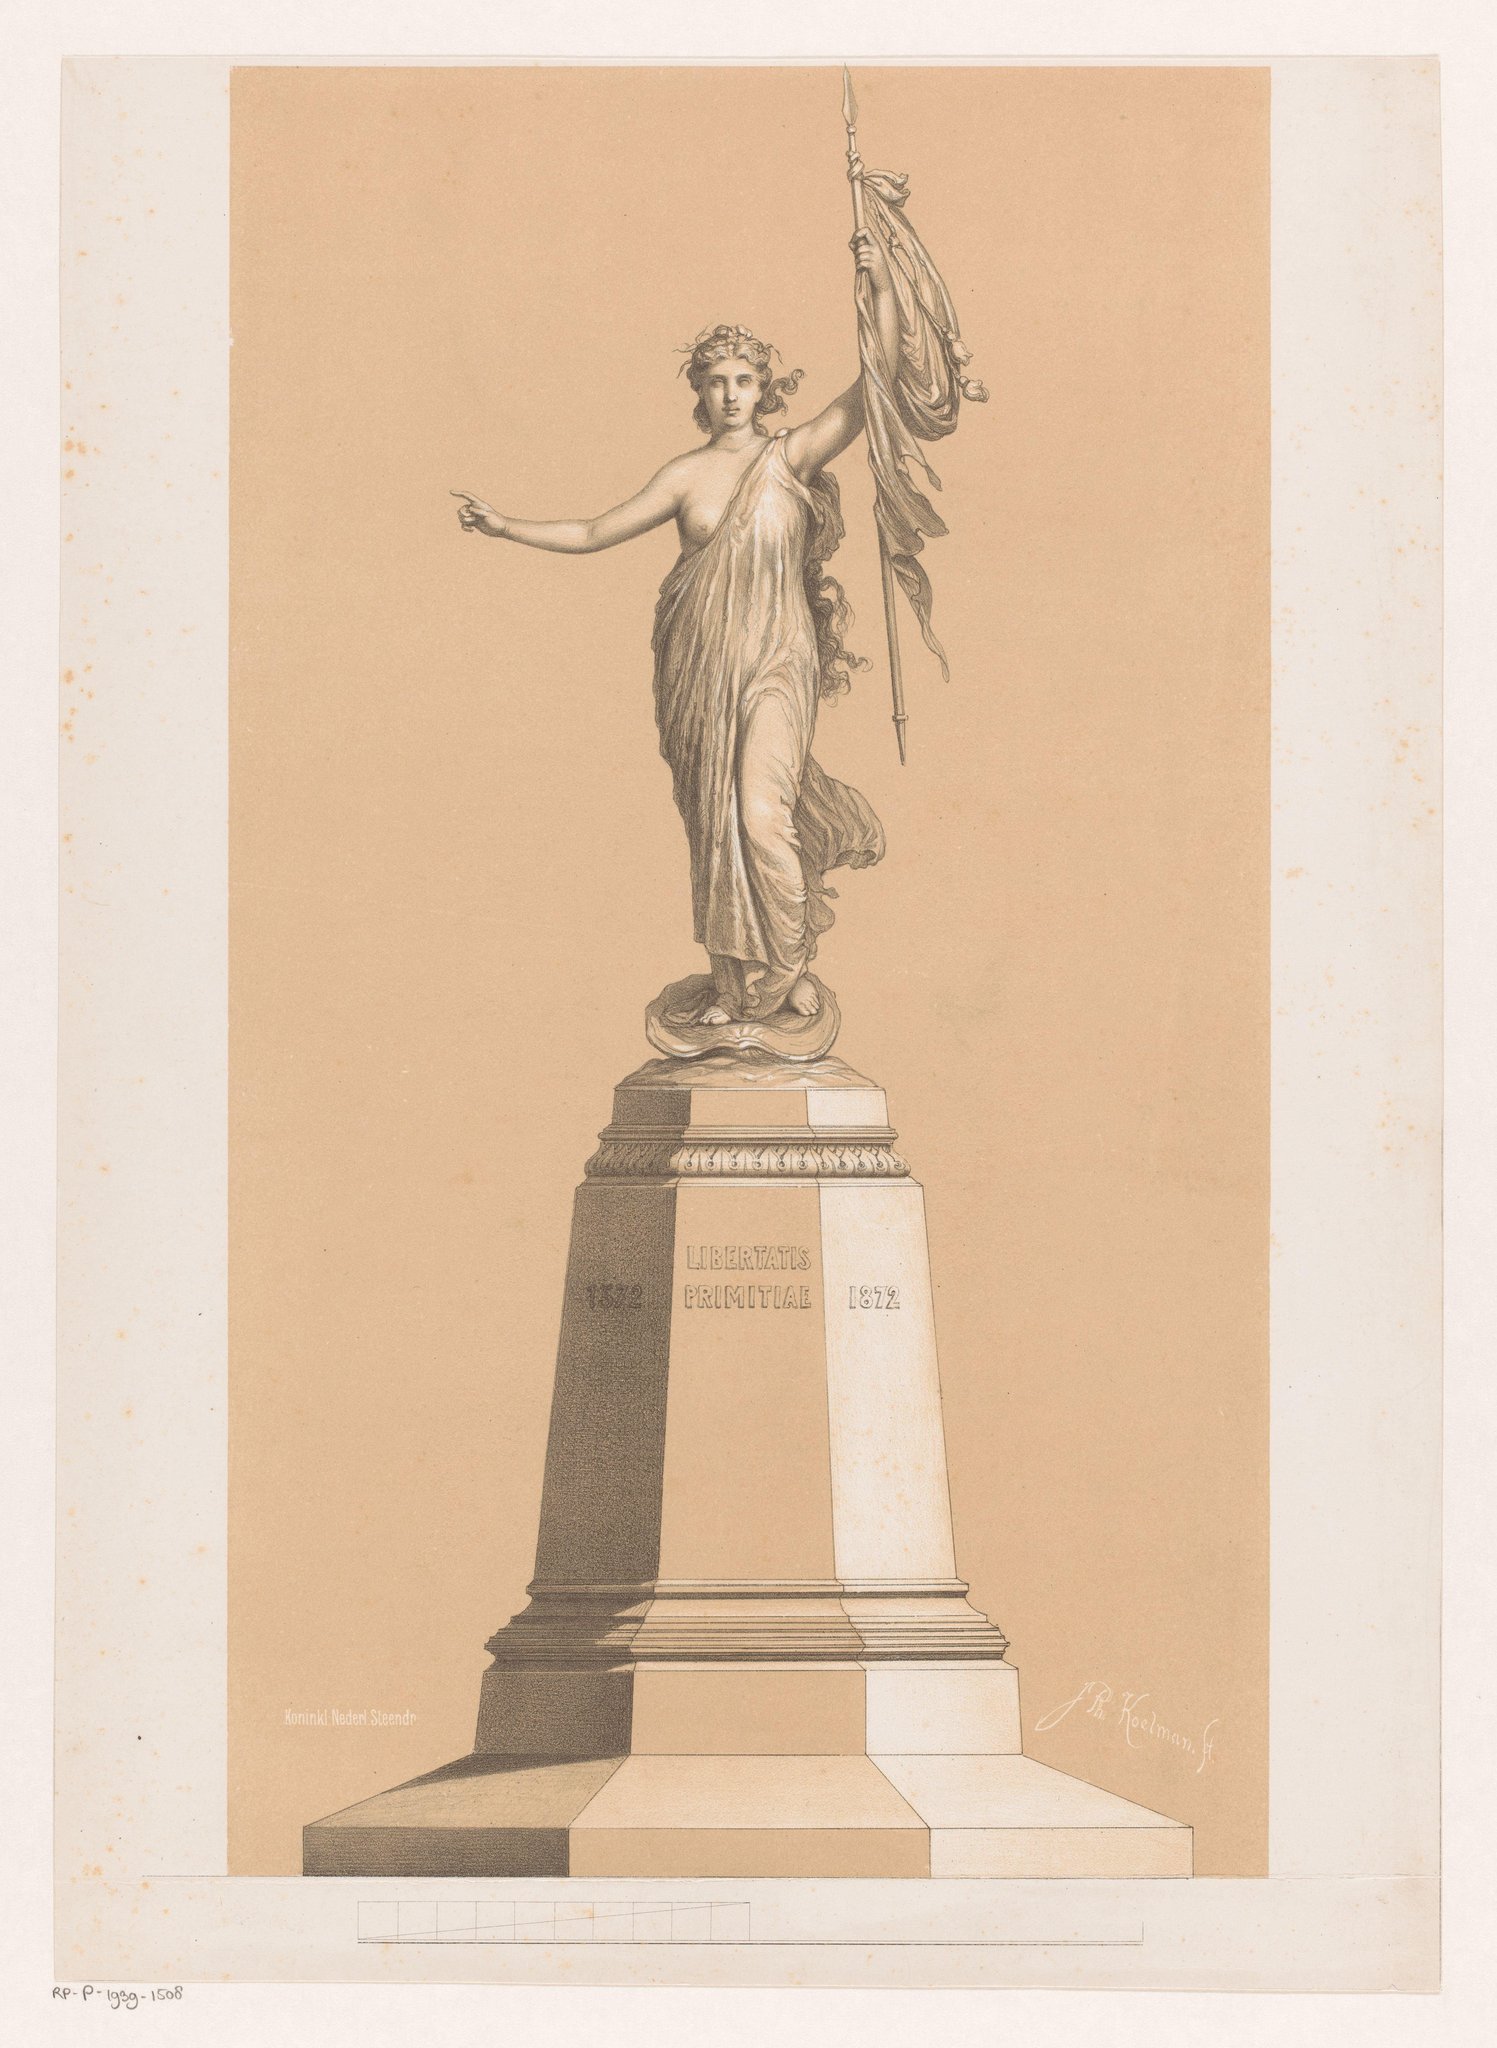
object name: print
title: Monument De Nymph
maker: johan philip koelman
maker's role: draughtsman, painter, print maker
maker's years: 1818-1893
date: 1872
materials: paper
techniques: tone lithography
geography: netherlands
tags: nymphs (in general); 'ninfe in commune' (ripa), monument, statue, brielle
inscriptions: collector's mark: Lugt 2166, collector's mark: Lugt 2228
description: Met haar rechterhand wijst de vrouw in de richting van de Maas vanwaar de Watergeuzen de vrijheid brachten. In haar linkerhand heeft zij een vlag. Het jaartal 1852 herinnert aan de bevrijding van Den Briel. In 1872 werd de eerste steen voor het monument gelegd.